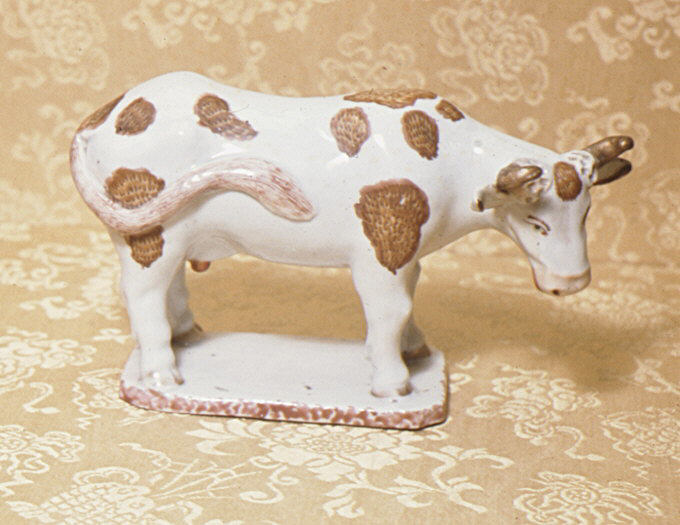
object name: figure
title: Cow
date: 1750-1770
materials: hard paste porcelain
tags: cows